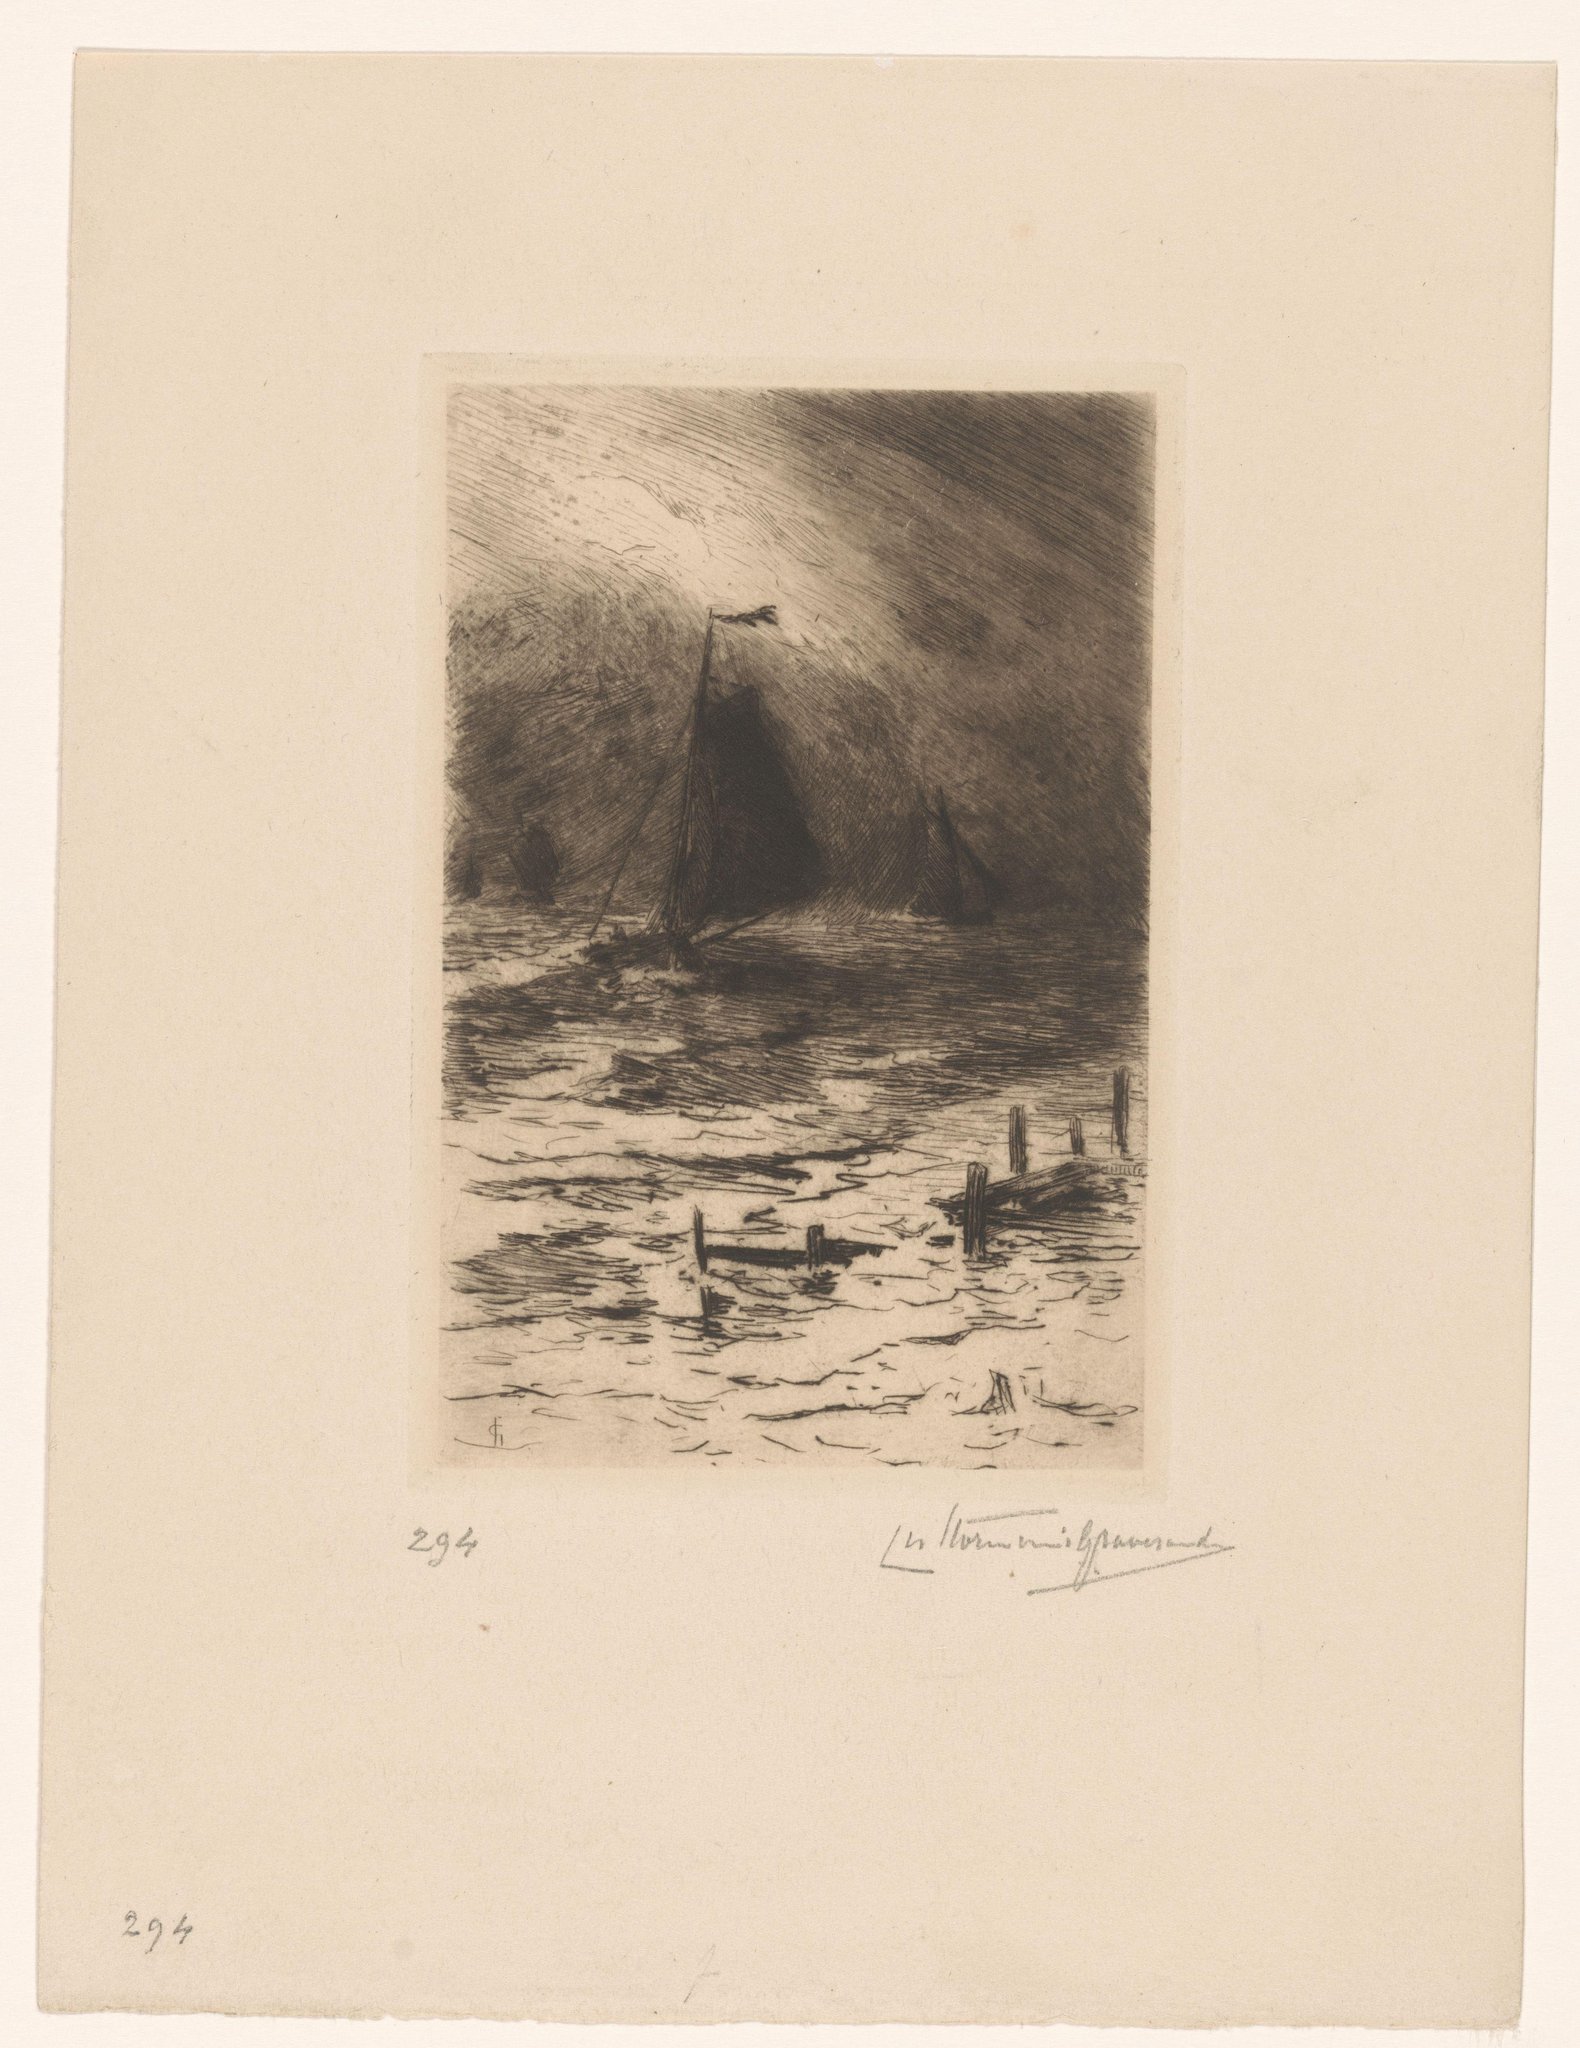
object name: print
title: Zeilboten op de Schelde bij nacht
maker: carel nicolaas storm van s-gravesande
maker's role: draughtsman, print maker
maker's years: 1841-1924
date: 1889-1903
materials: paper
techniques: drypoint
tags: sailing-ship, sailing-boat, river, night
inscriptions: number: ‘294’, collector's mark: Lugt 2228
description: Mogelijk vermeld in: Storm van 's-Gravesande, Charles. Catalogue des eaux-fortes et lithographies. New York: s.n., 1903, of in een onbekende latere uitgave van het manuscript. Vermoedelijk vermeld als catalogusnummer 294.